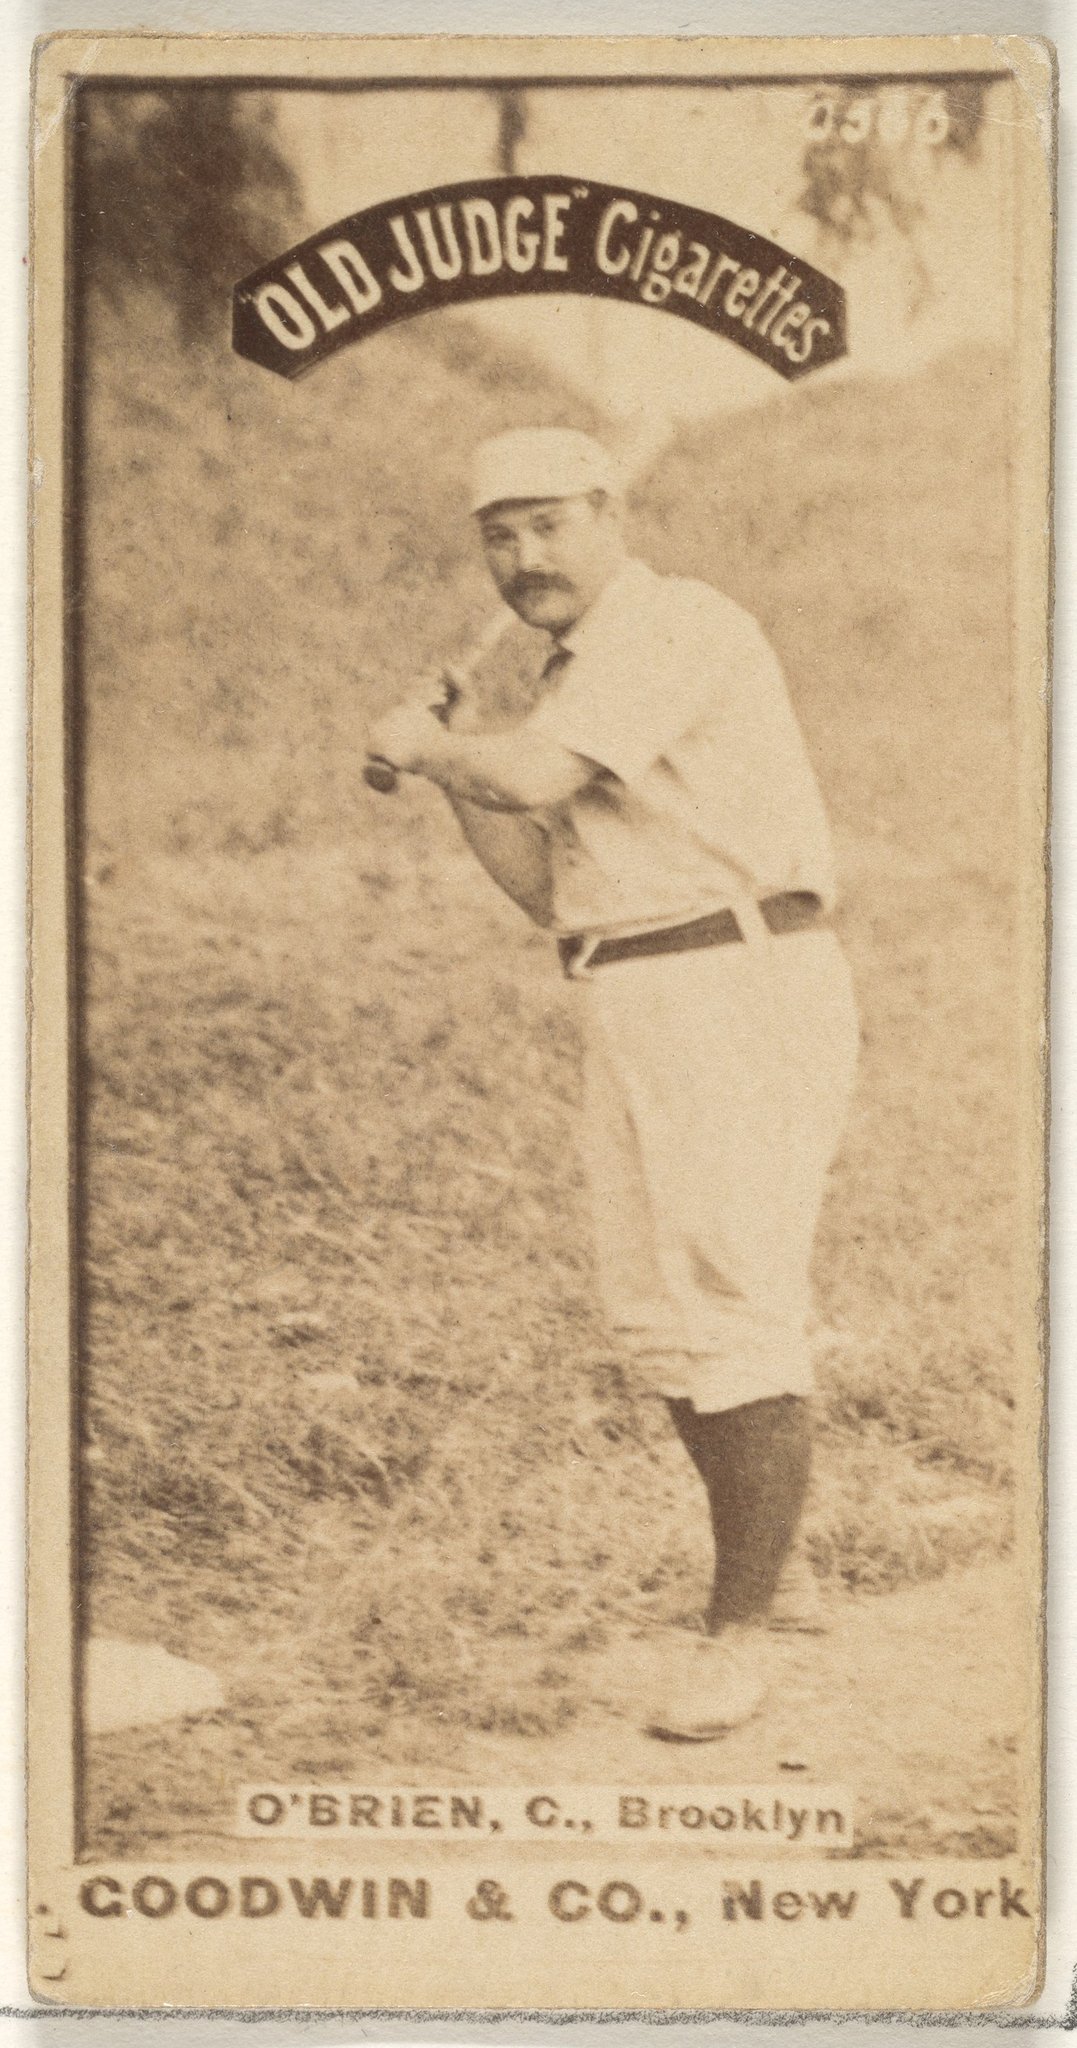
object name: baseball card, photograph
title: O'Brien, Catcher, Brooklyn, from the Old Judge series (N172) for Old Judge Cigarettes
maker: goodwin & company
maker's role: publisher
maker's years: 1850-1950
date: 1887-1890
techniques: albumen silver print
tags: men,portraits,baseball,athletes